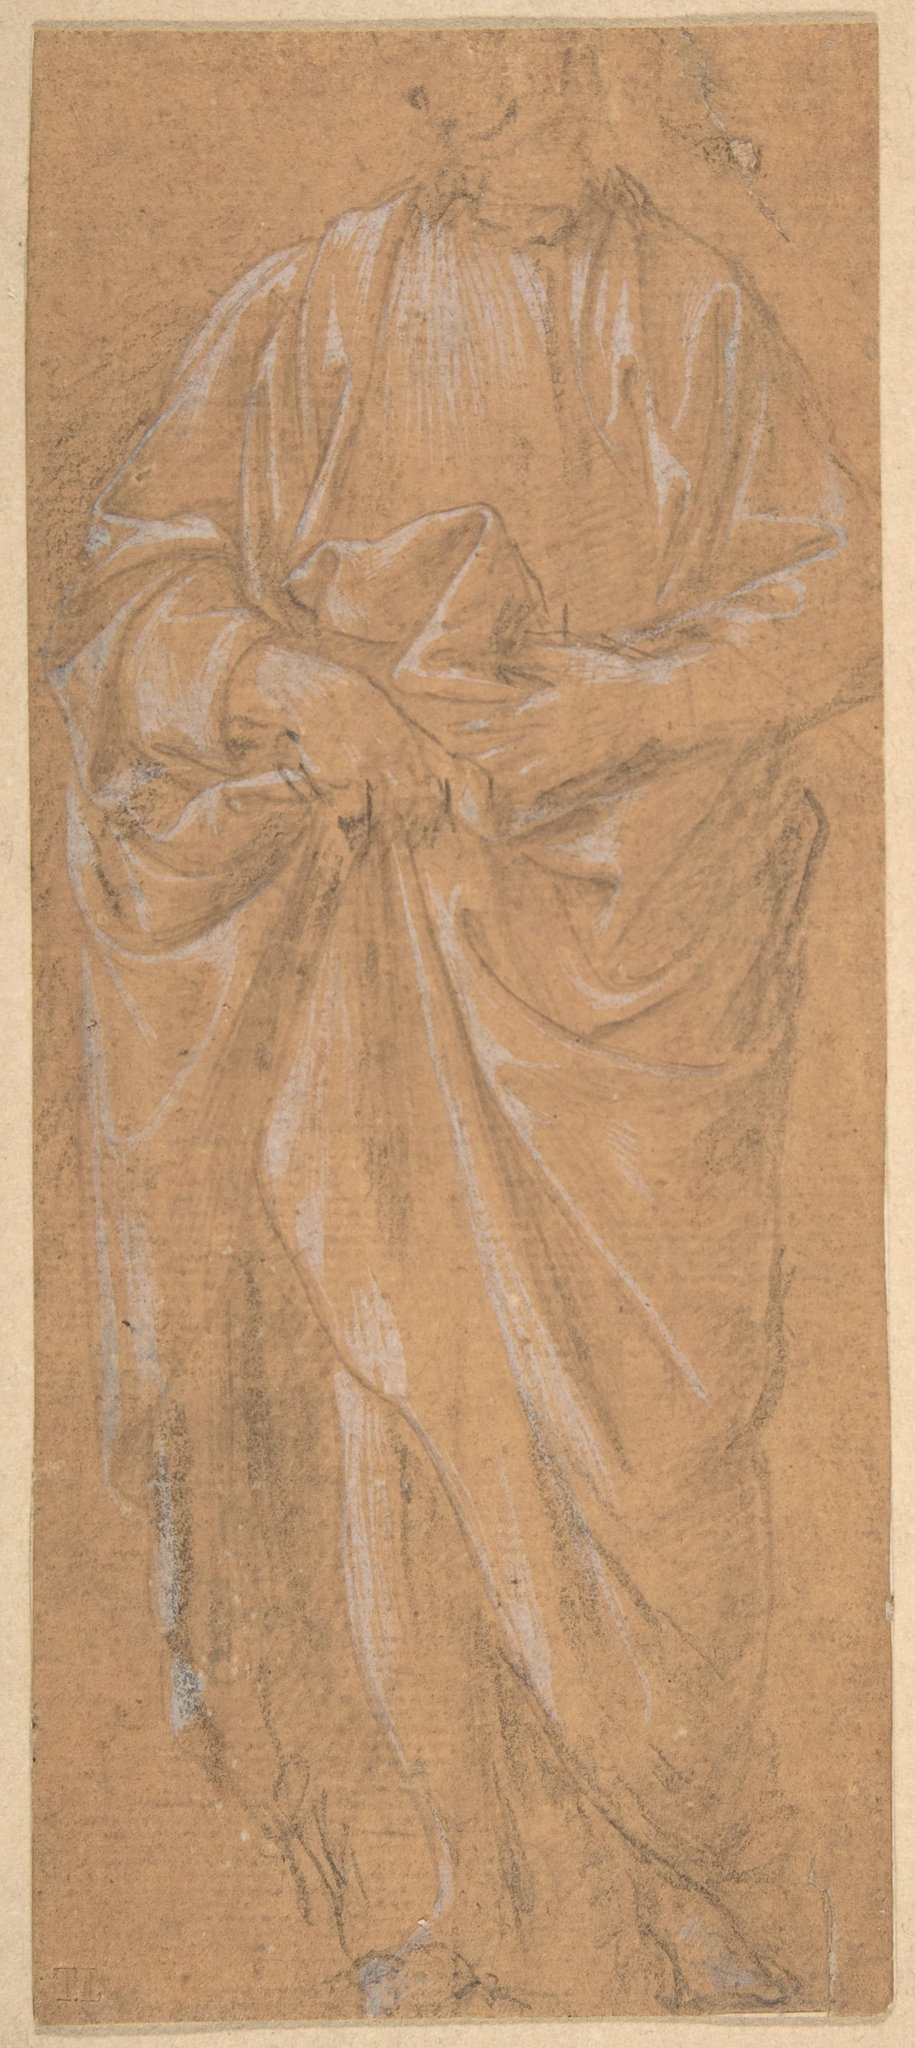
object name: drawing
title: Standing Male Figure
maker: filippino lippi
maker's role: artist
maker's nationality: italian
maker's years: 1457-1504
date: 1480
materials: gouache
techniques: highlighting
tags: men